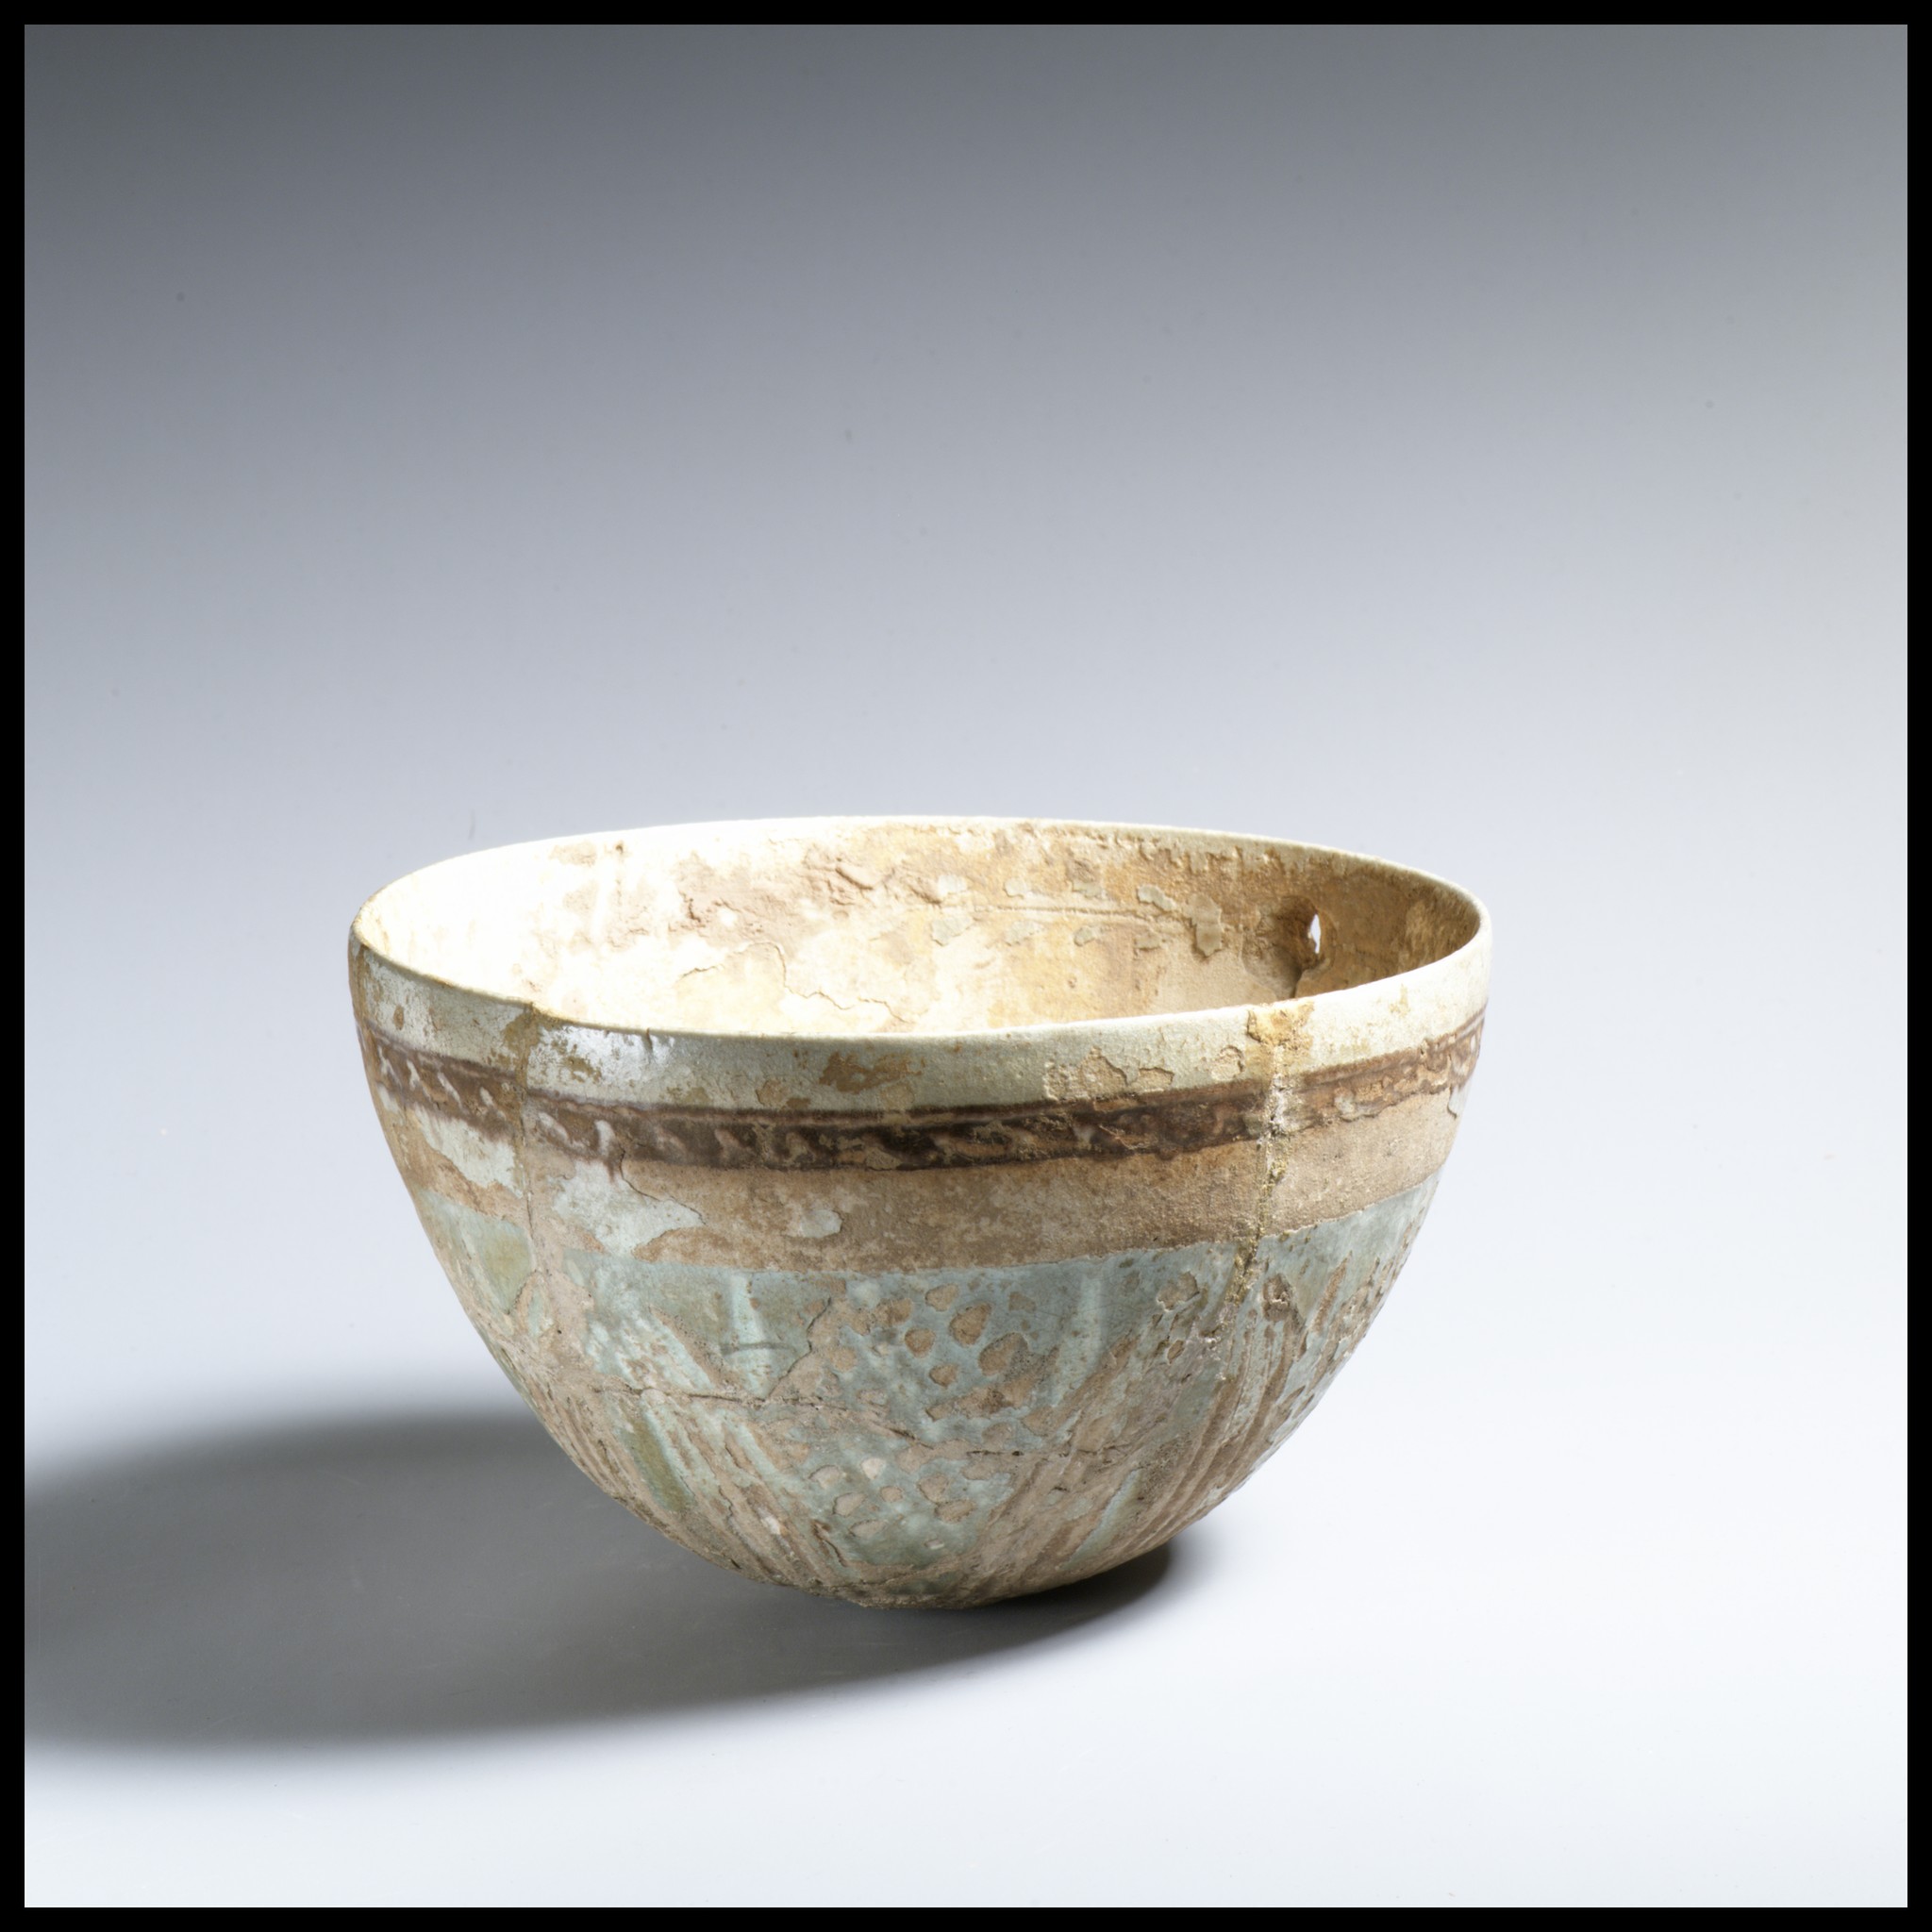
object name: bowl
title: Faience bowl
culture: greek, ptolemaic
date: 200-1 BCE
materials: faience